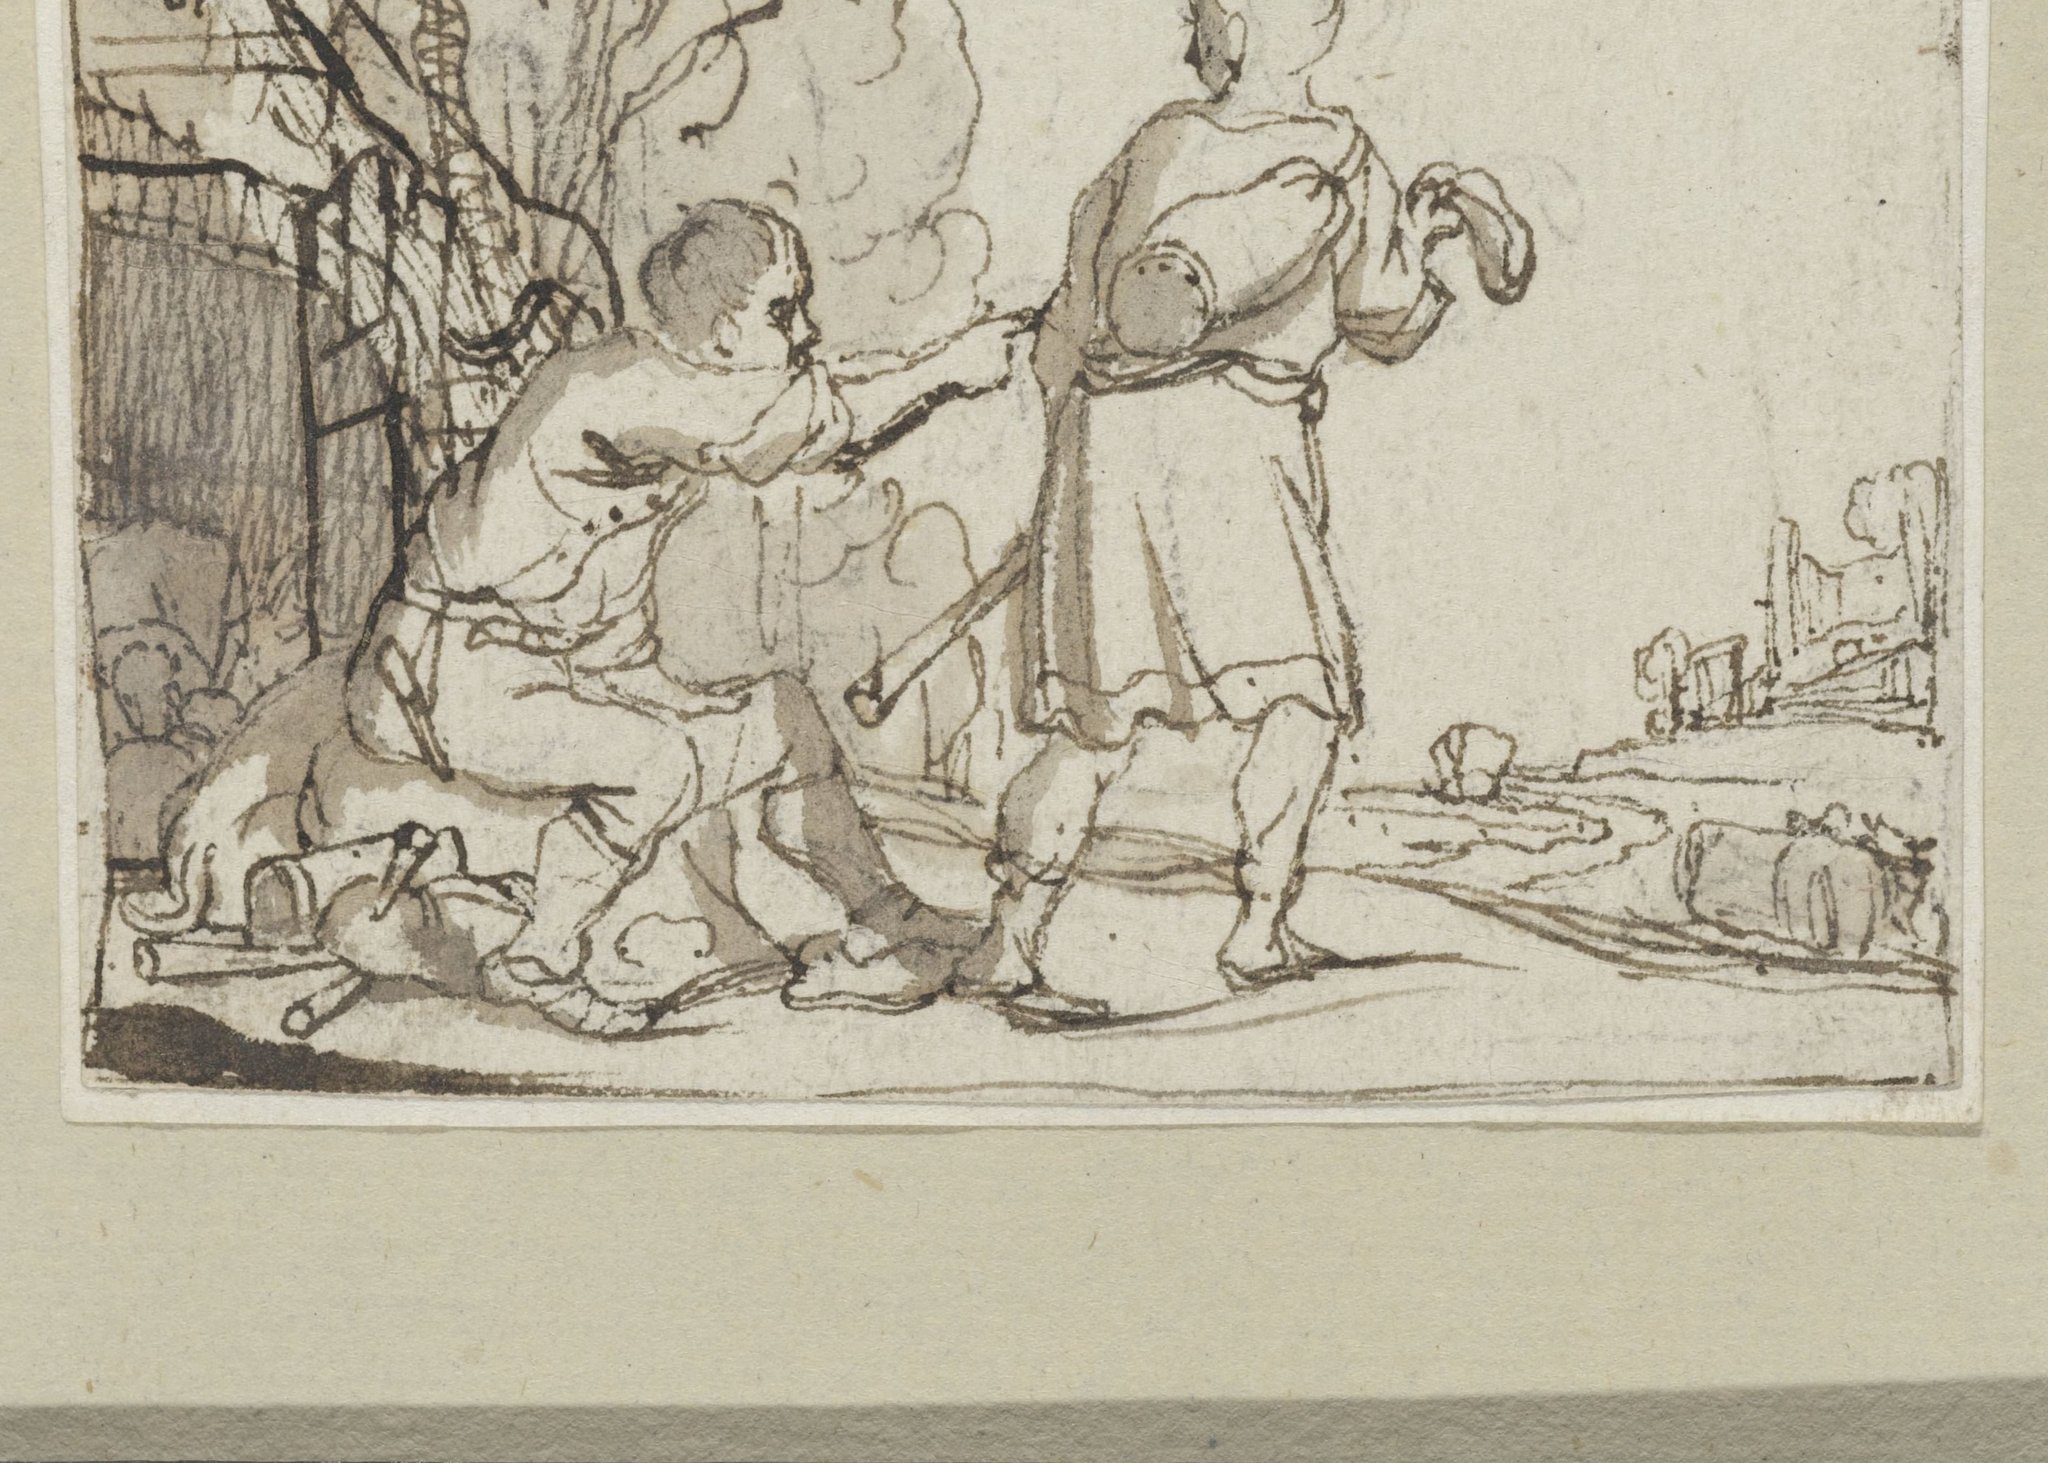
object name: drawing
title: Een zittende en een staande man in een landschap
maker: Anonymous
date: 1600-1699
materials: ink, paper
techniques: brush, pen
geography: netherlands